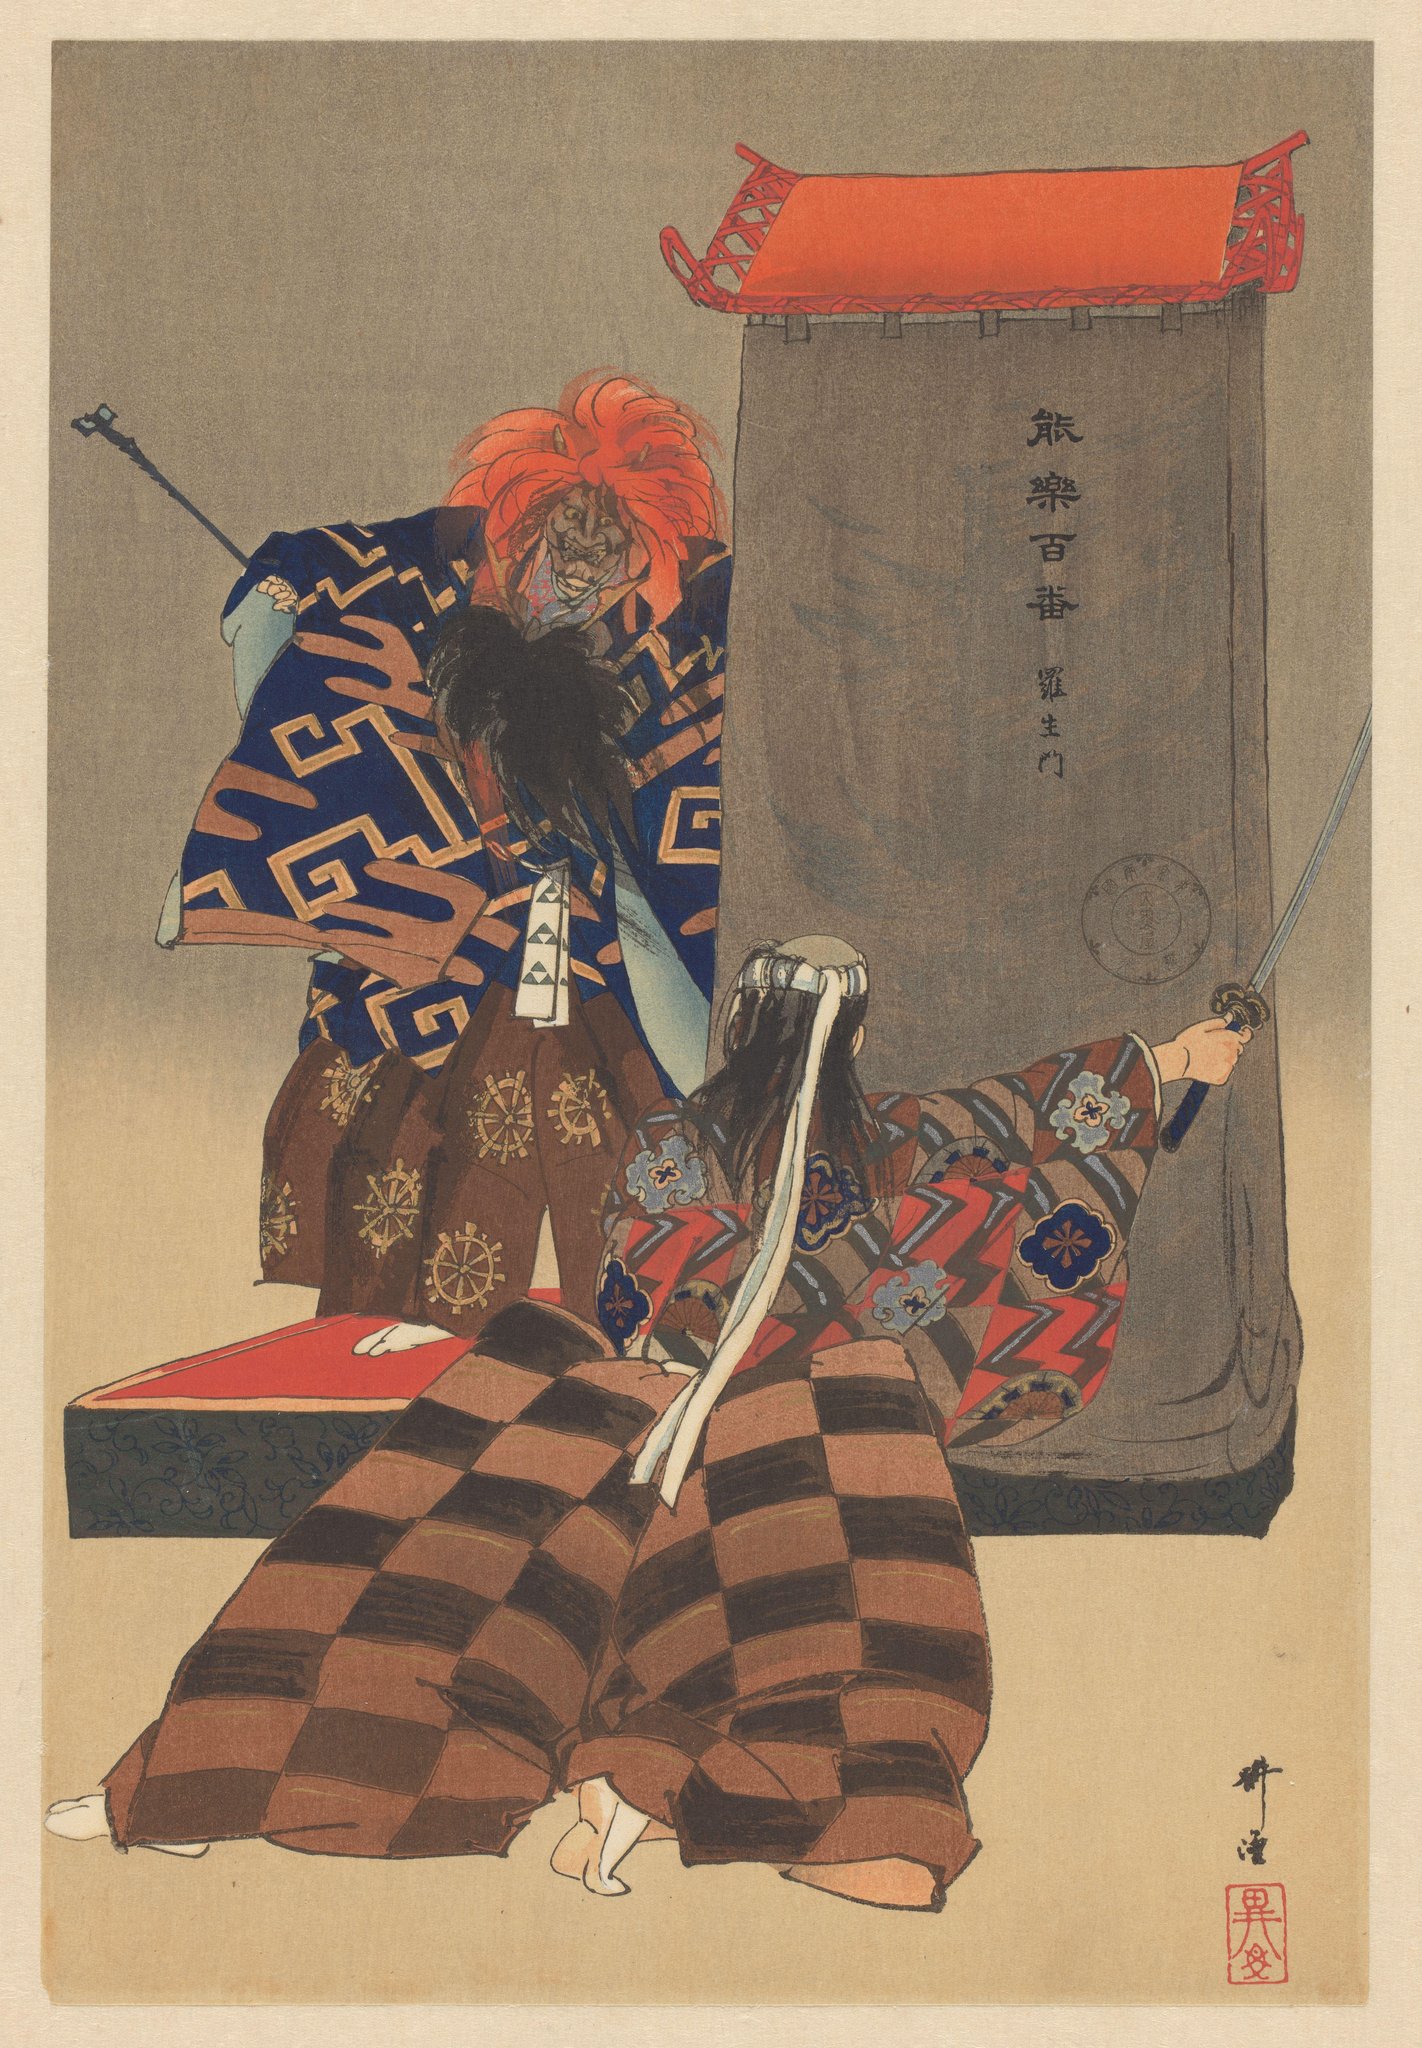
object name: print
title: Scene uit het Noh theaterstuk Rashomon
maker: tsukioka kôgyo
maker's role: print maker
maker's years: 1869-1927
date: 1922-1926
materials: paper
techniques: woodcut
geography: japan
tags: adult man (+ two persons), group of actors, troupe; actors on the stage, civic architecture; edifices; dwellings, japan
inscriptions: collector's mark: Lught 2760, collector's mark: Lugt 2228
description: Twee acteurs (één op de rug gezien) in een scène uit het Noh theaterstuk Rashomon.